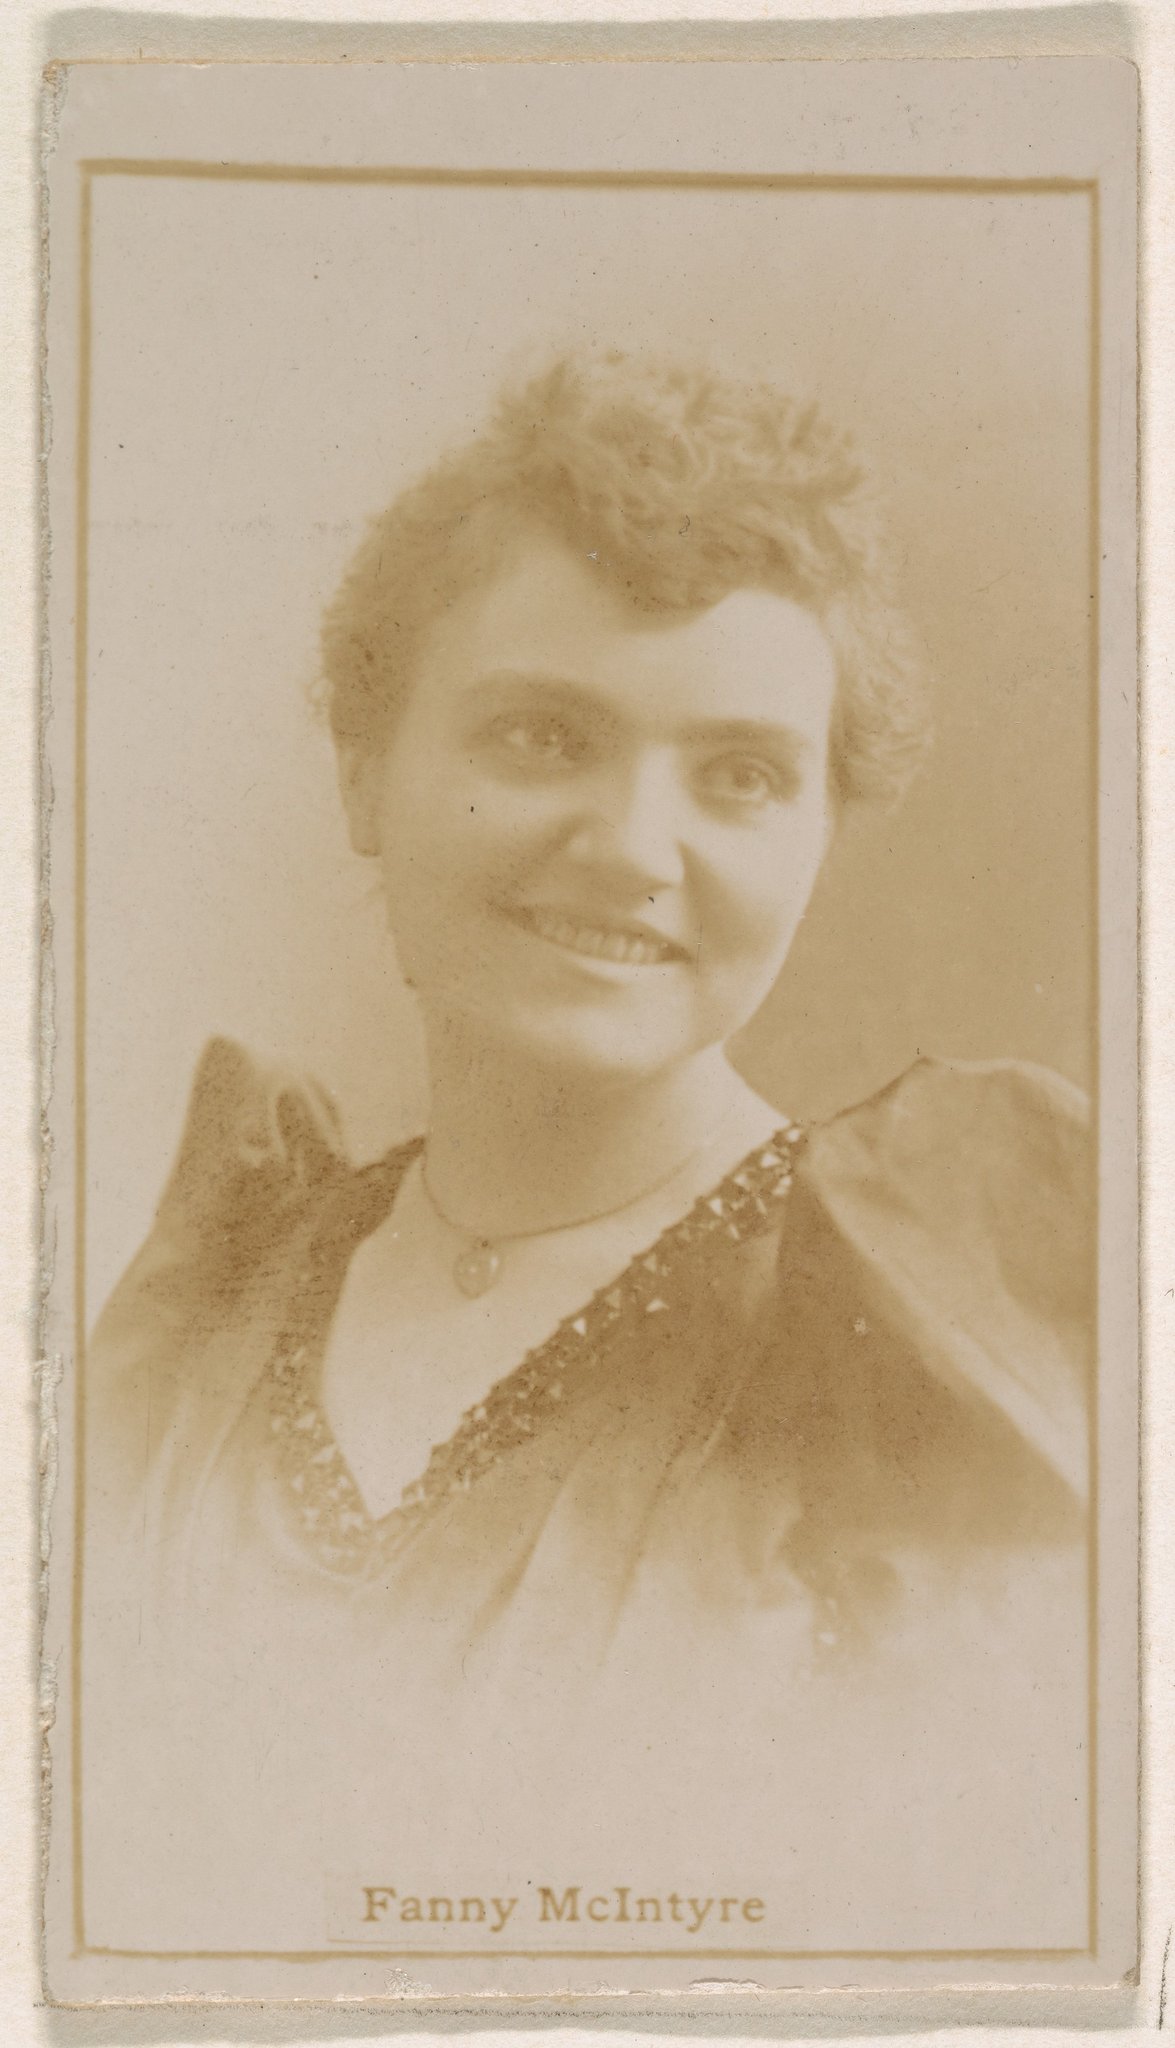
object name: photograph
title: Fanny McIntyre, from the Actresses series (N245) issued by Kinney Brothers to promote Sweet Caporal Cigarettes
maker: kinney brothers tobacco company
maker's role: publisher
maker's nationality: american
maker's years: 1869-2011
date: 1890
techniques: albumen silver print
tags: portraits,women,actresses